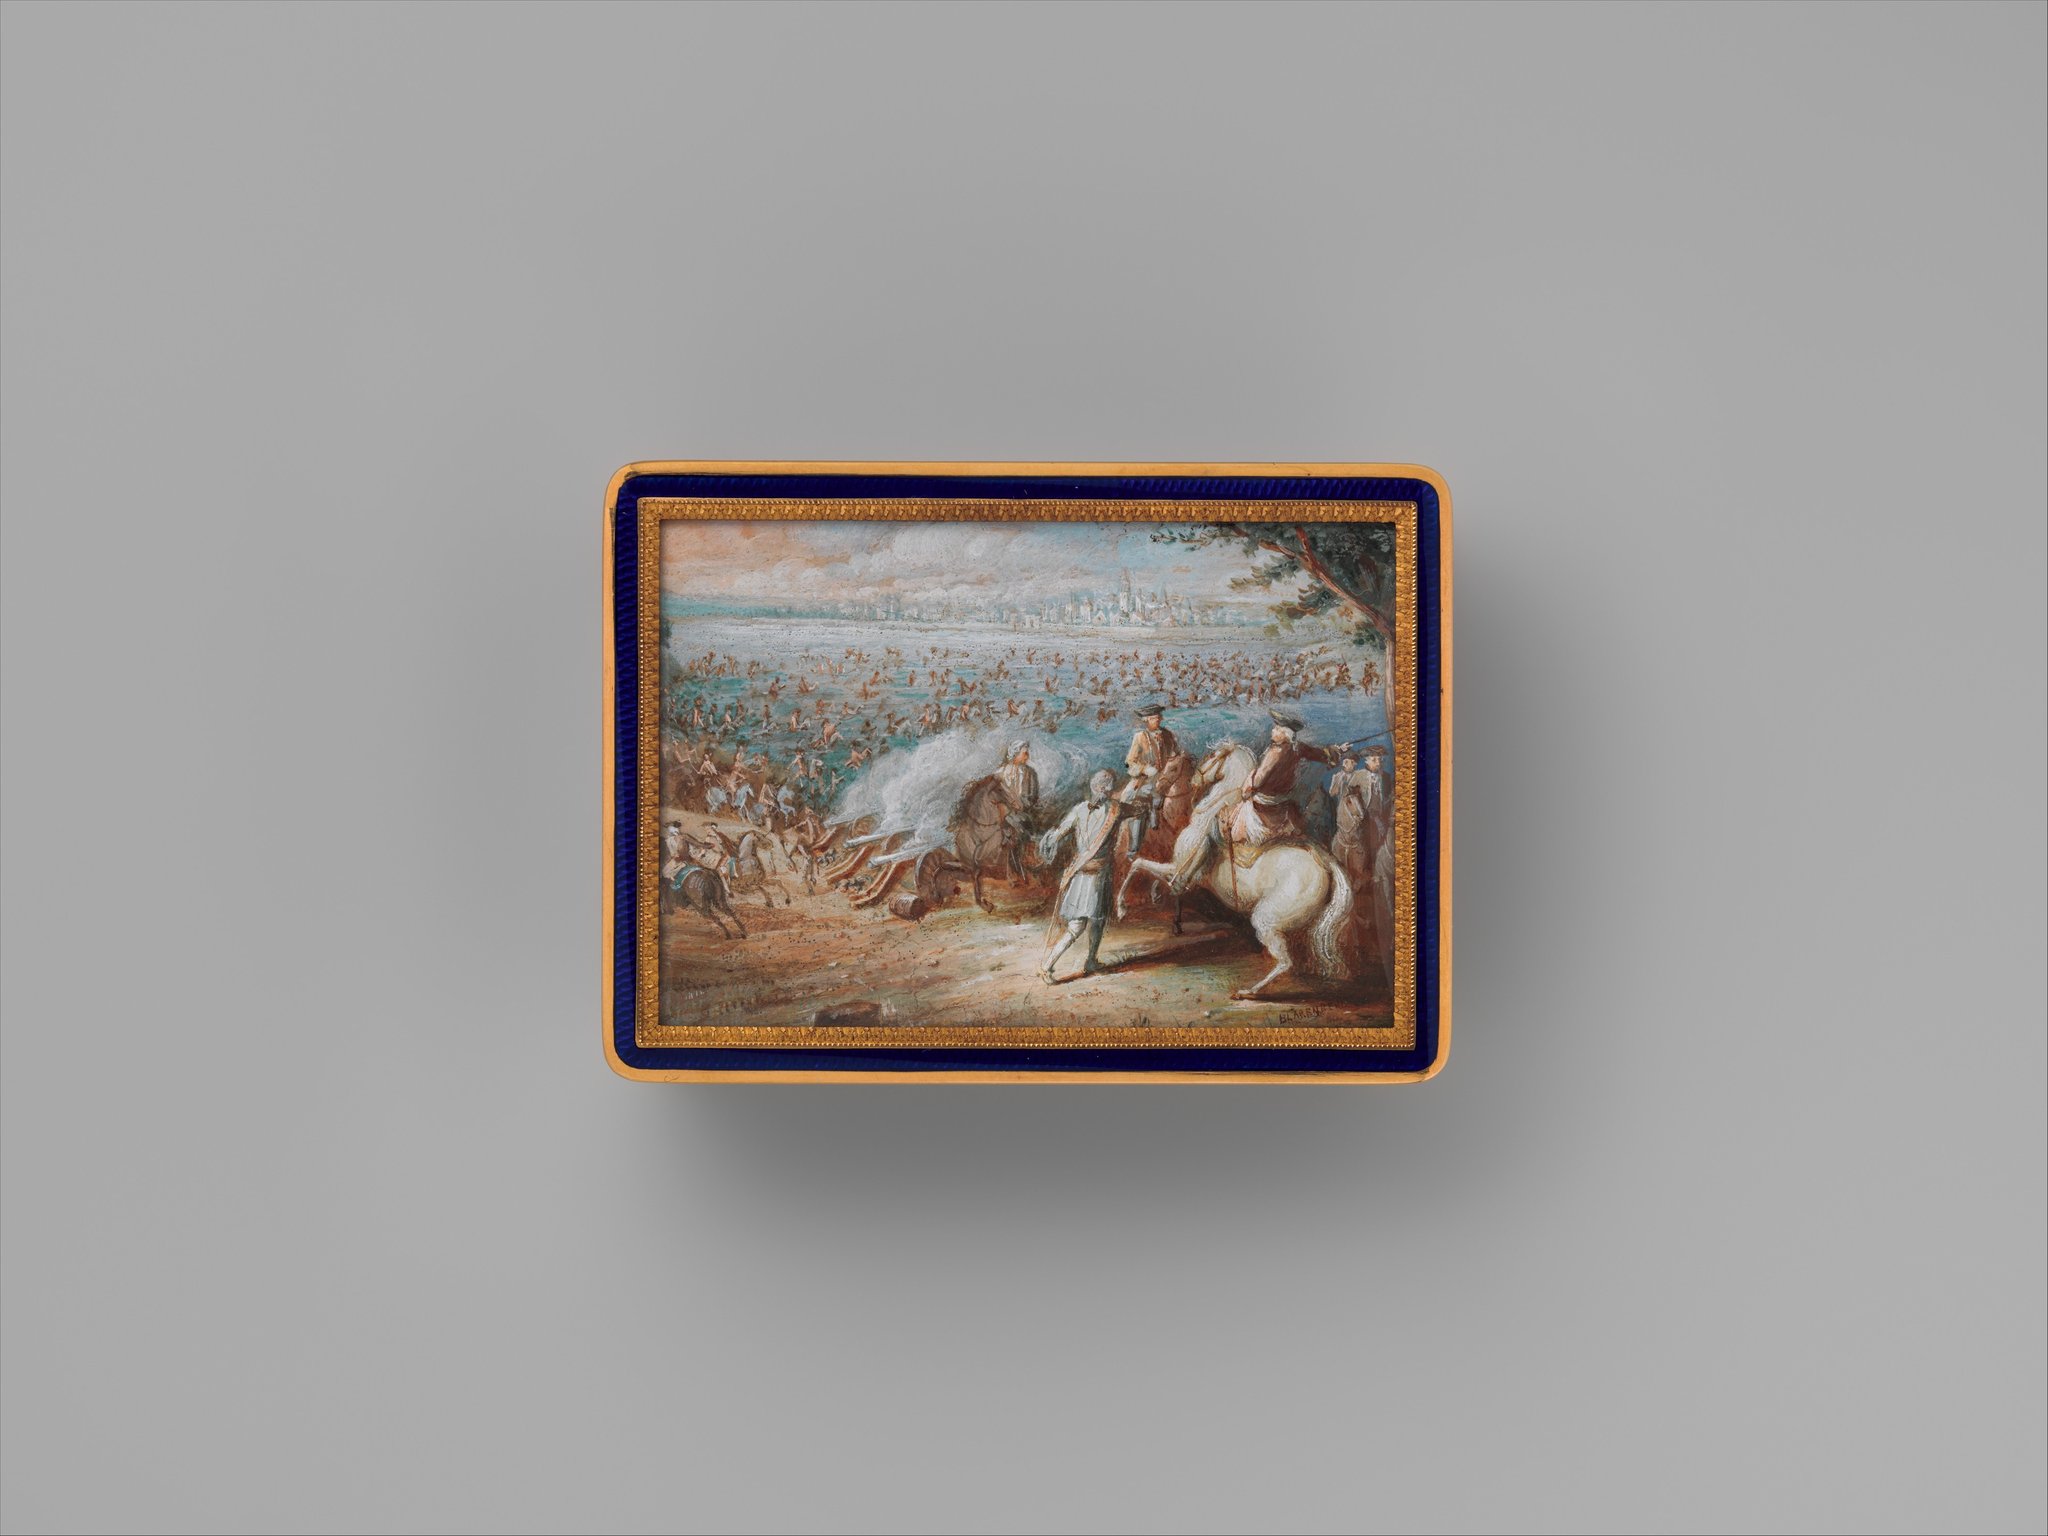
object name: snuffbox, painting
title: Snuffbox with four maritime scenes; Louis XIV crossing the Rhine in 1672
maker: adrien jean maximilien vachette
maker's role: maker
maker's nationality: french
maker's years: 1753-1839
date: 1798-1838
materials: enamel, gold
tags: battles,kings,louis xiv,horses